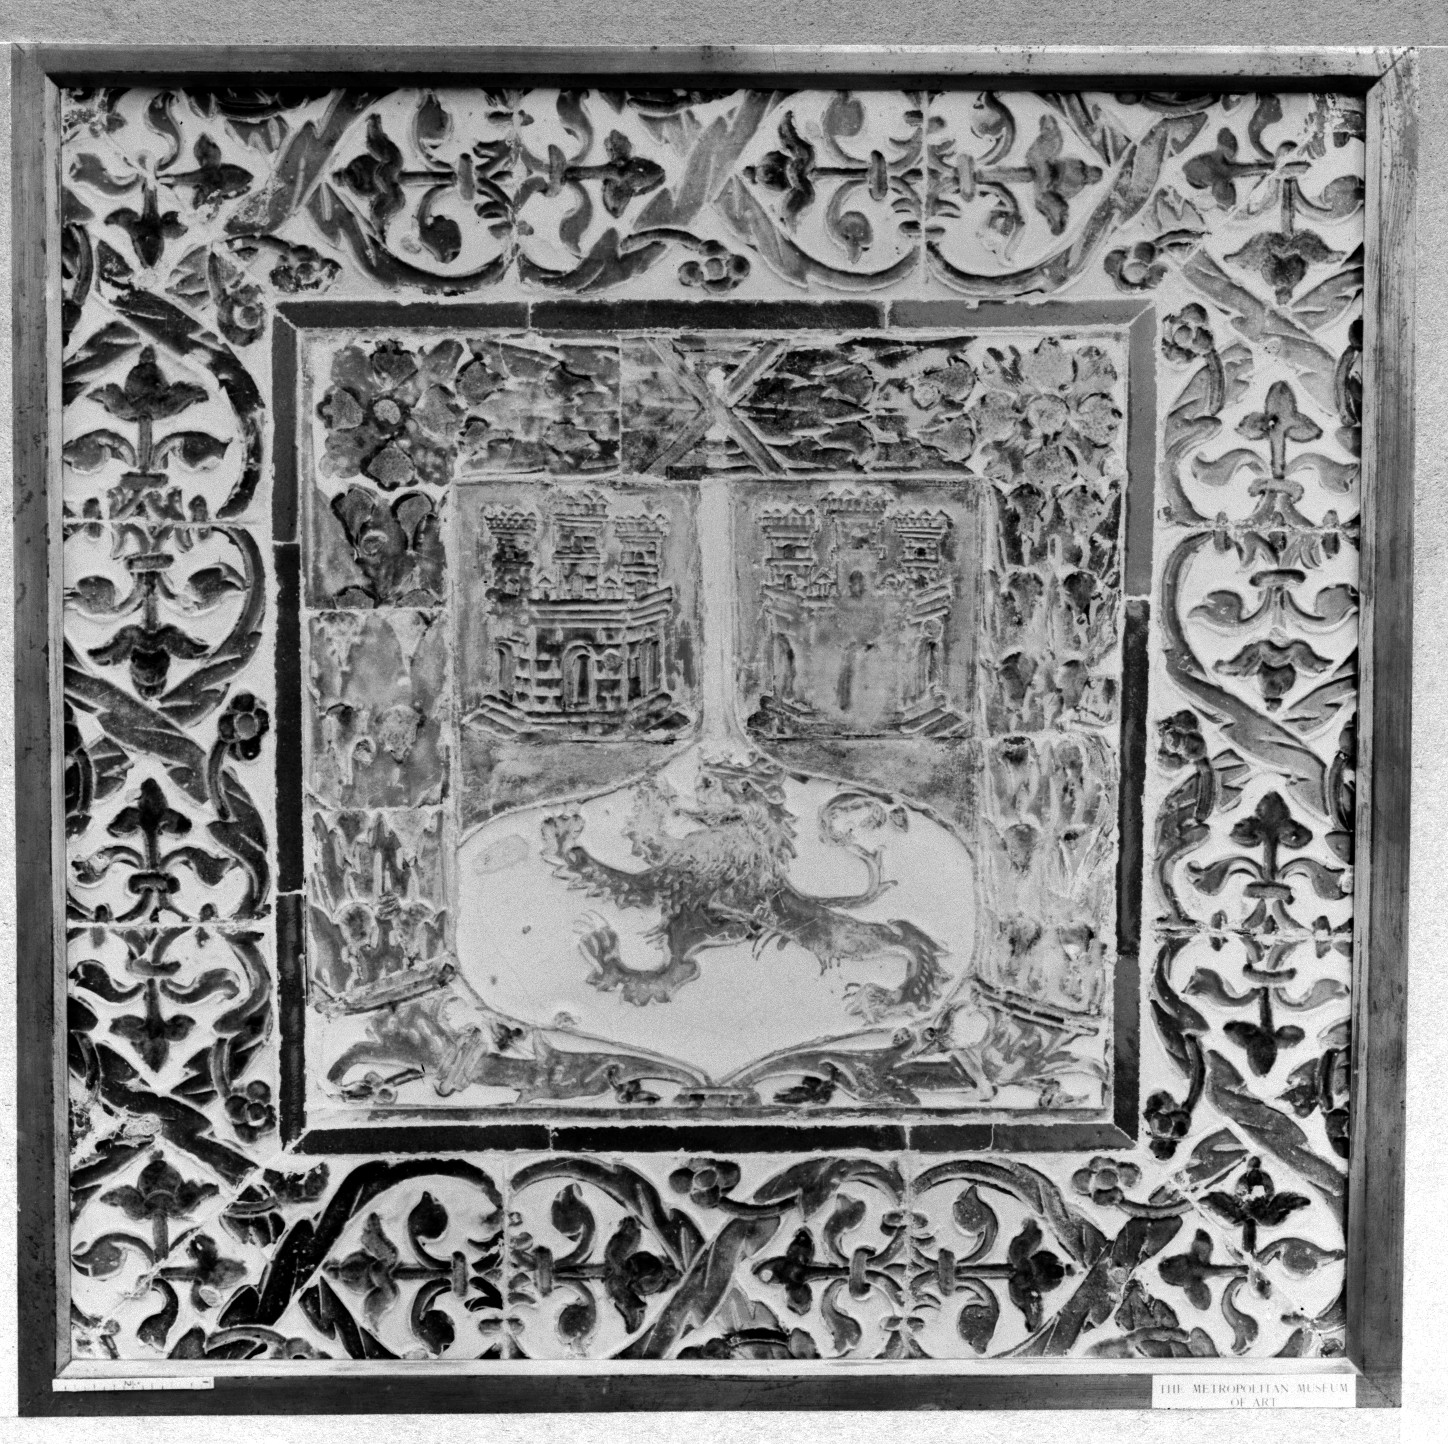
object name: wall tile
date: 1501-1600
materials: earthenware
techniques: luster painting, glazing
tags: coat of arms